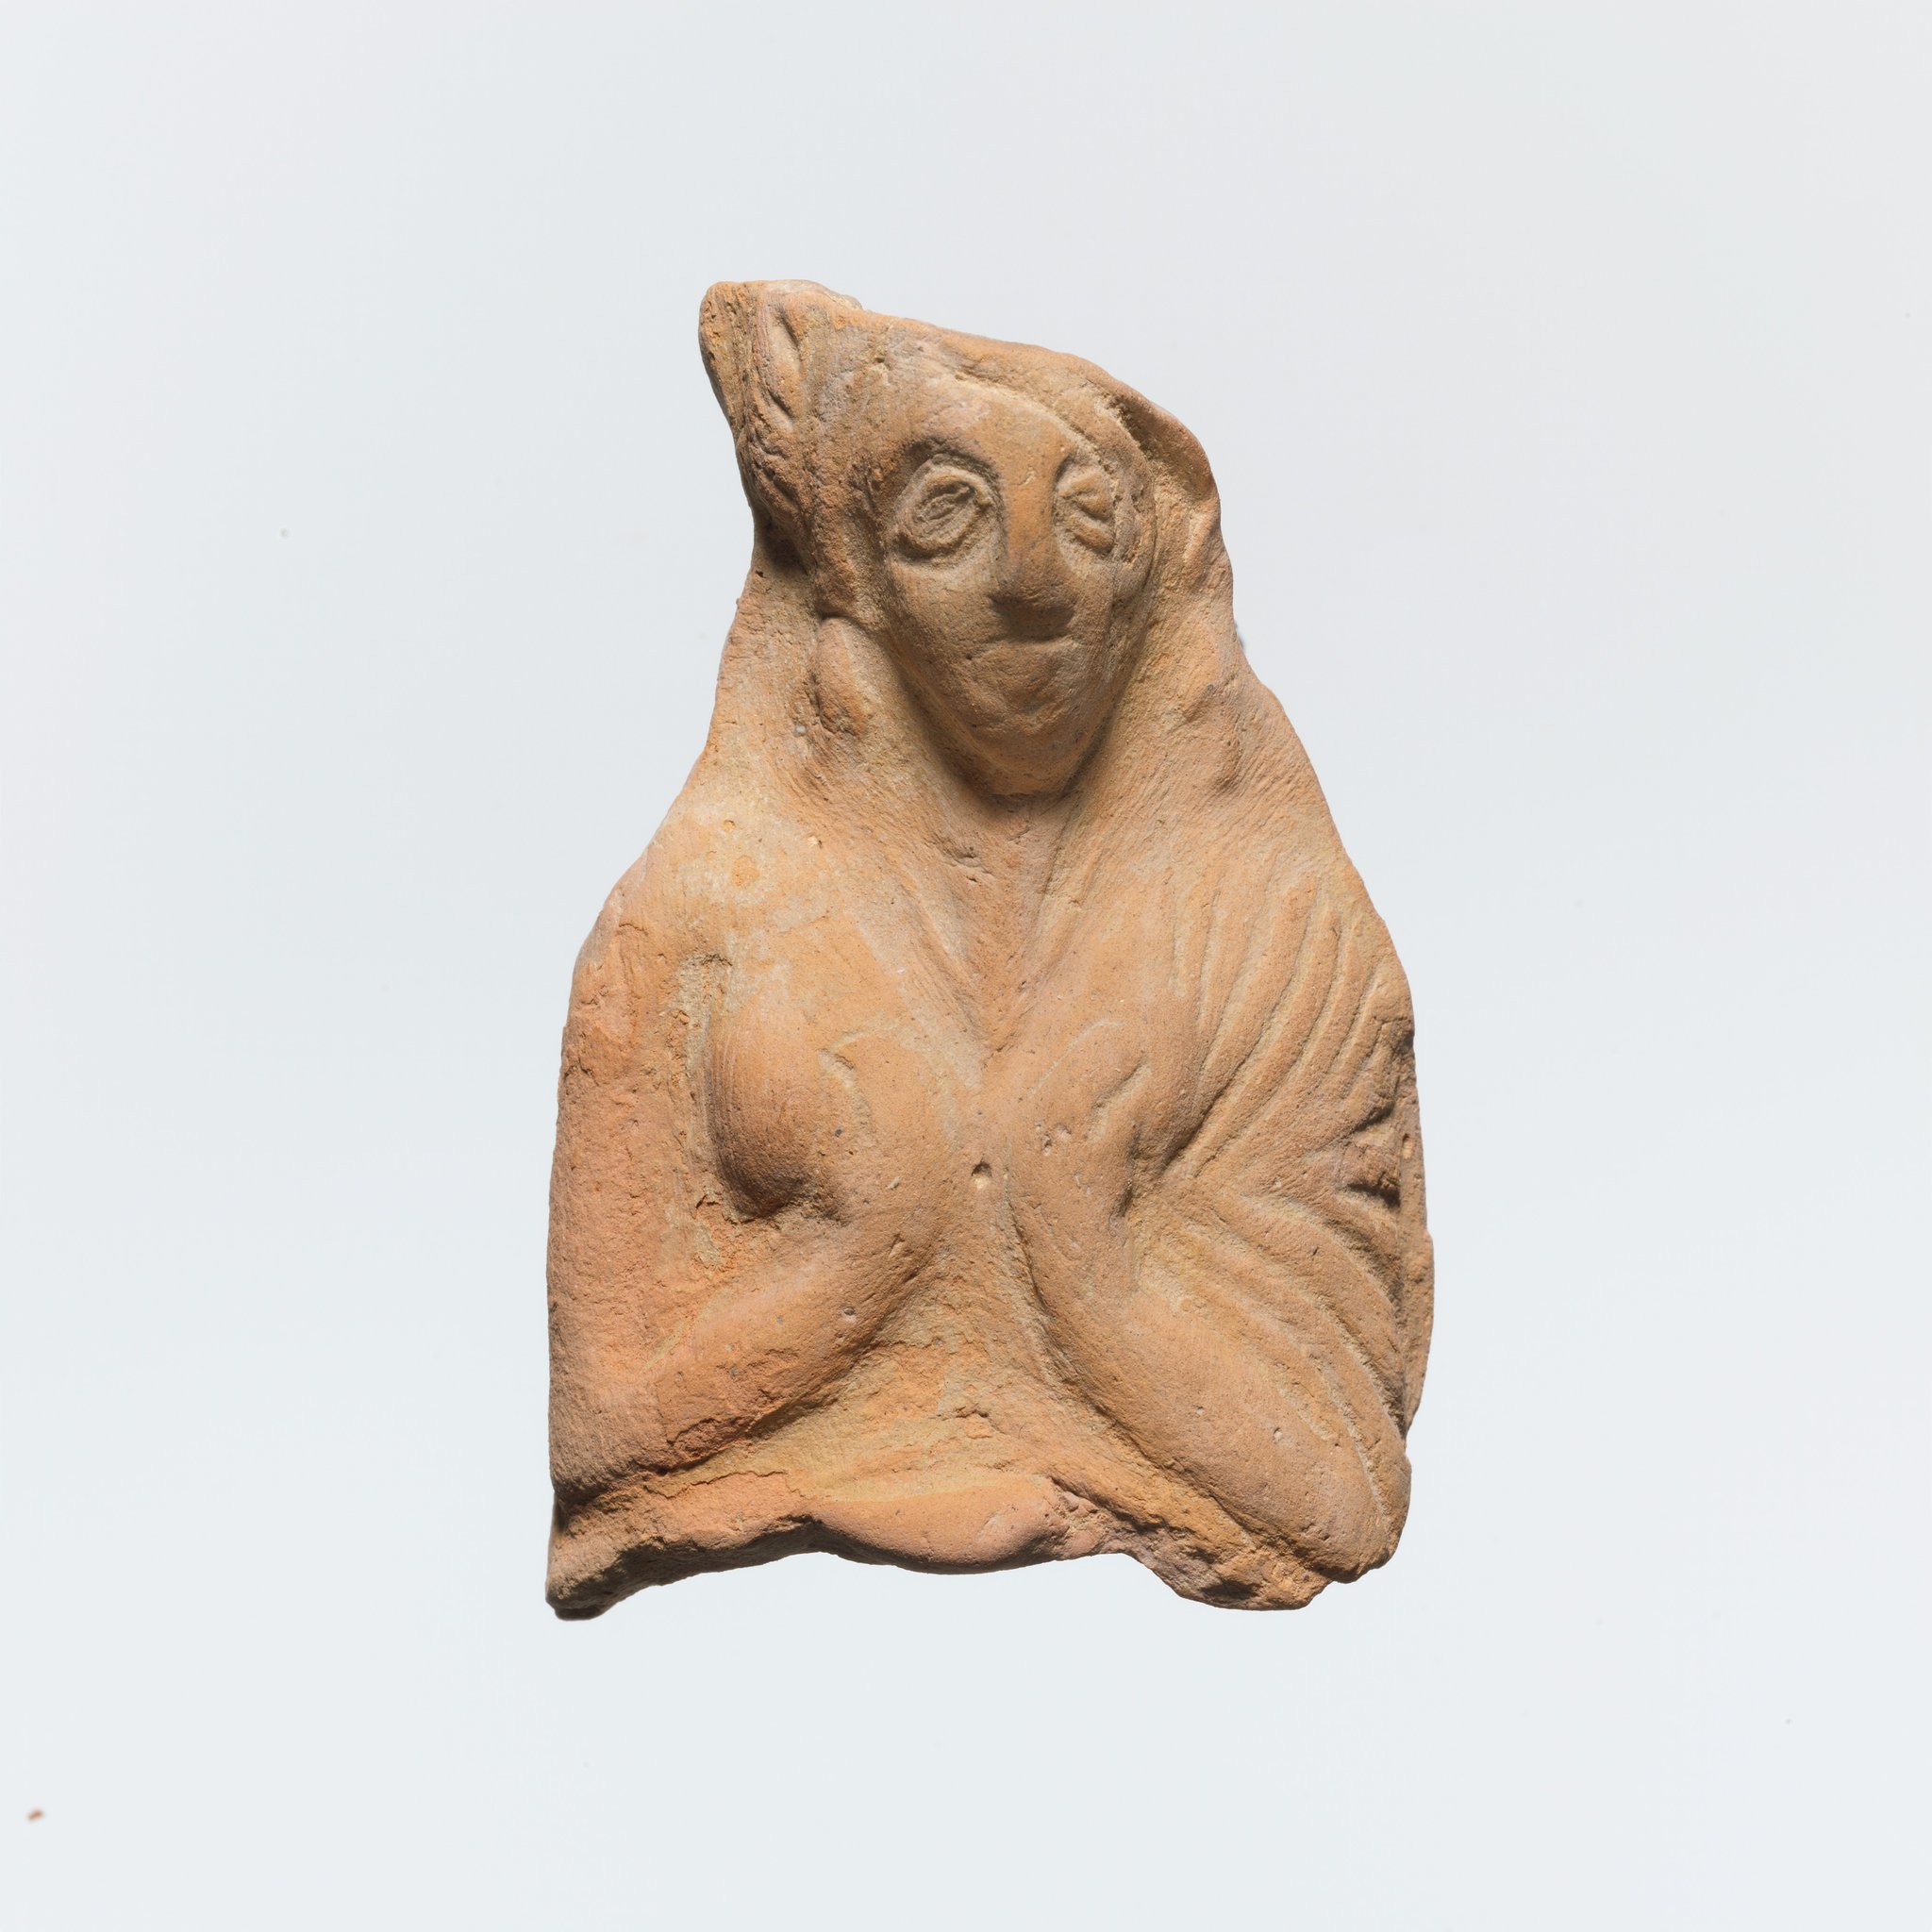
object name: bust of a female figure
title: Terracotta bust of a female figure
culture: greek, cretan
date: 600-401 BCE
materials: terracotta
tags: women